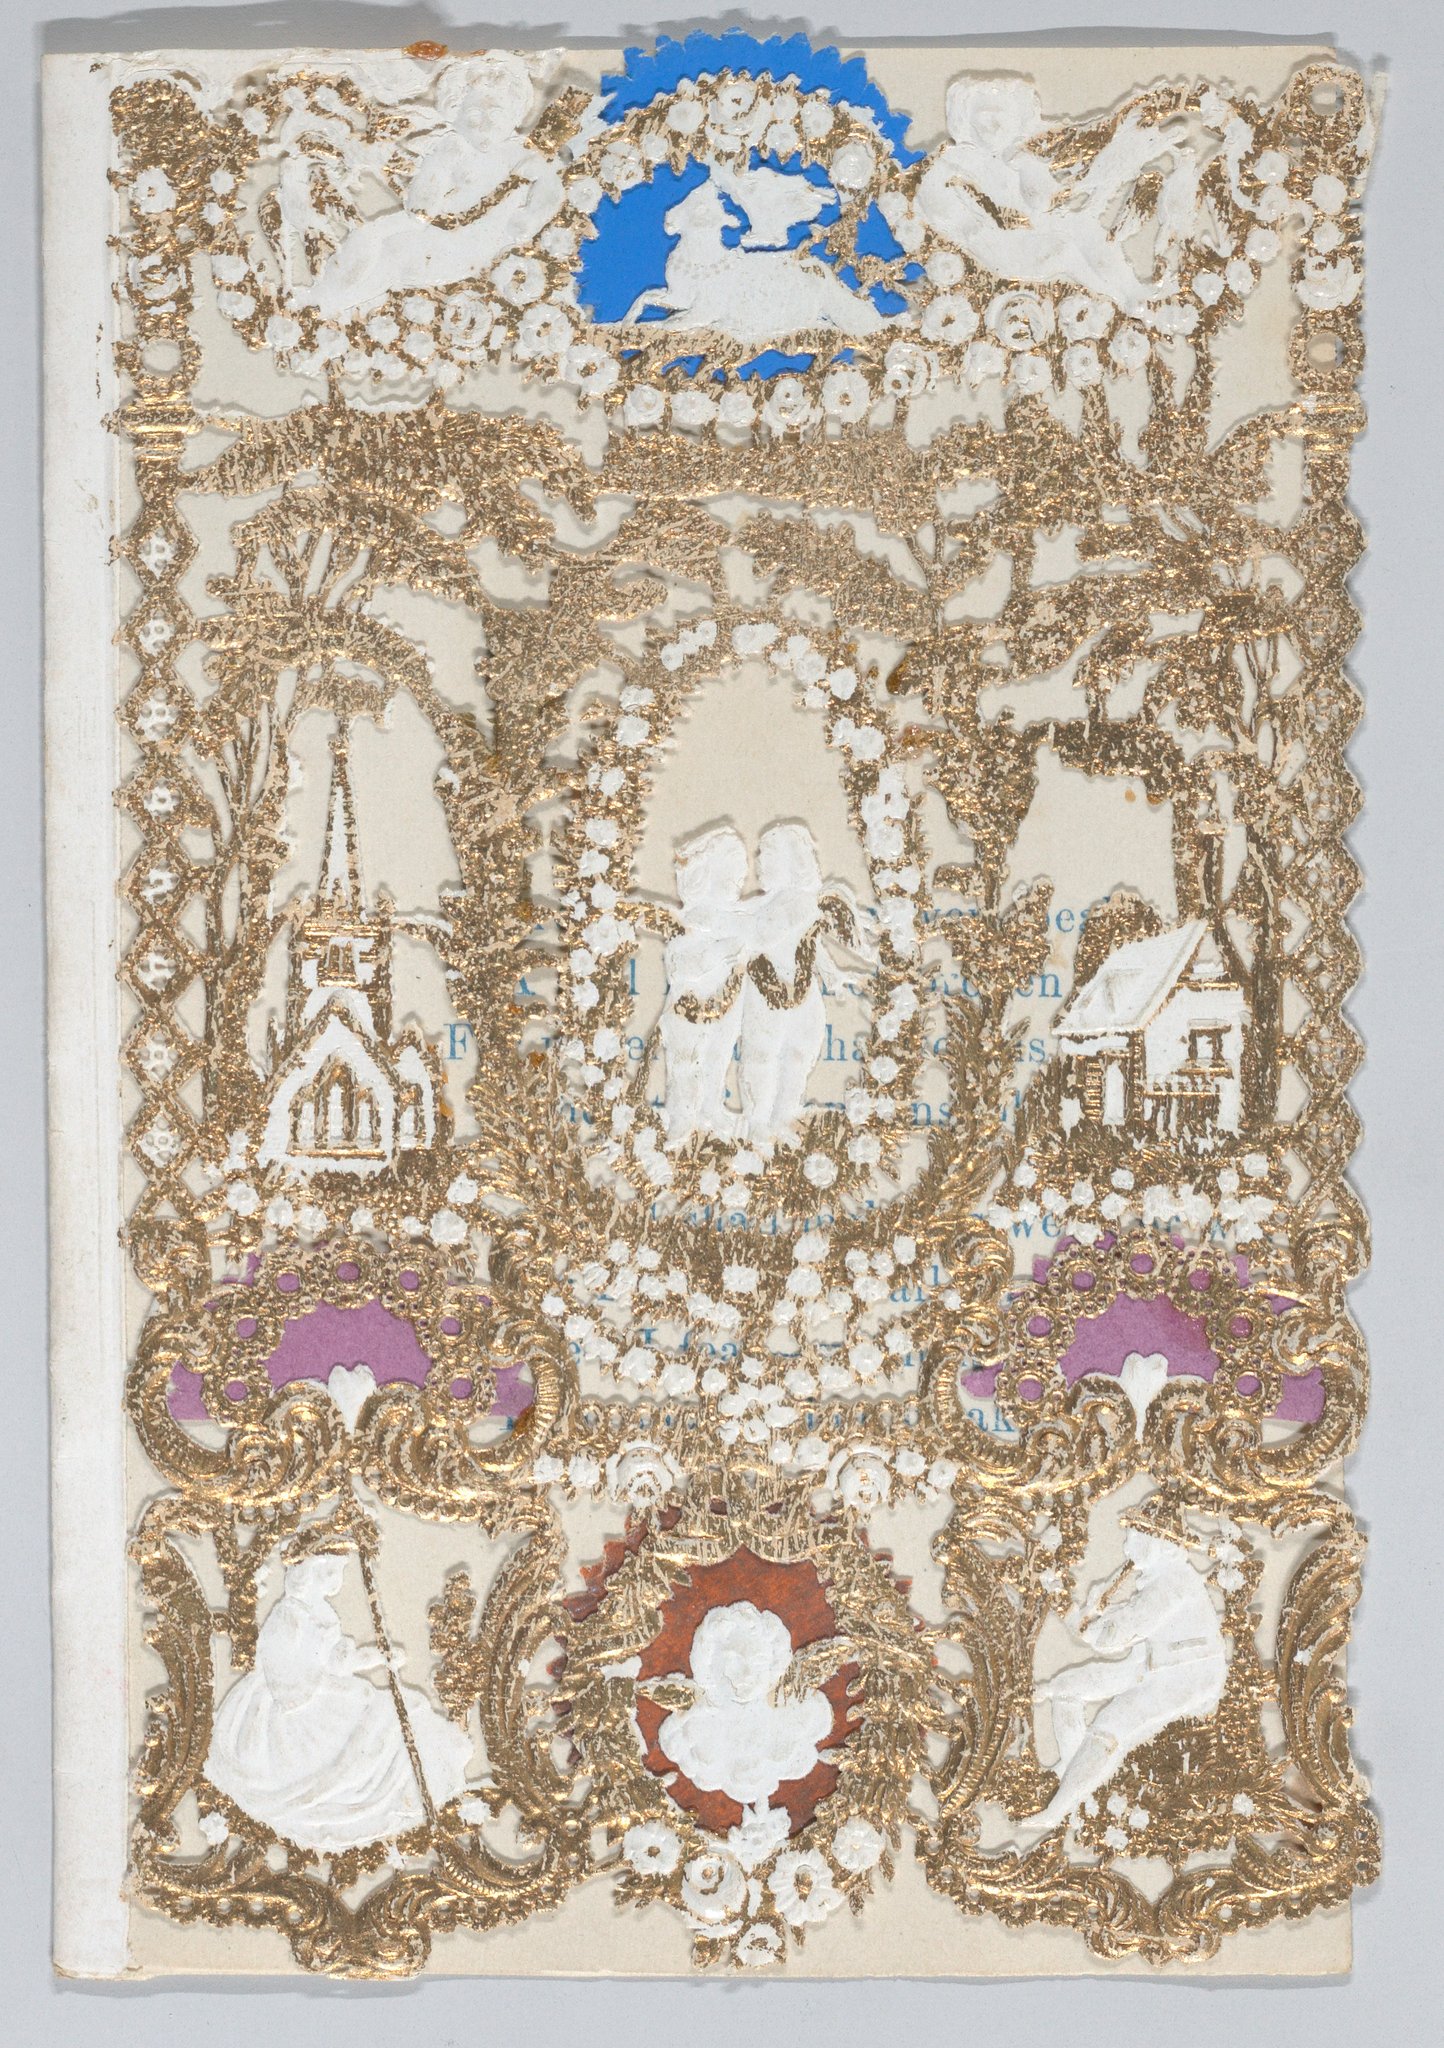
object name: valentine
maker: Anonymous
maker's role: artist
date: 1834-1866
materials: lace, paper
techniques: embossing, gilding, lithograph, open work